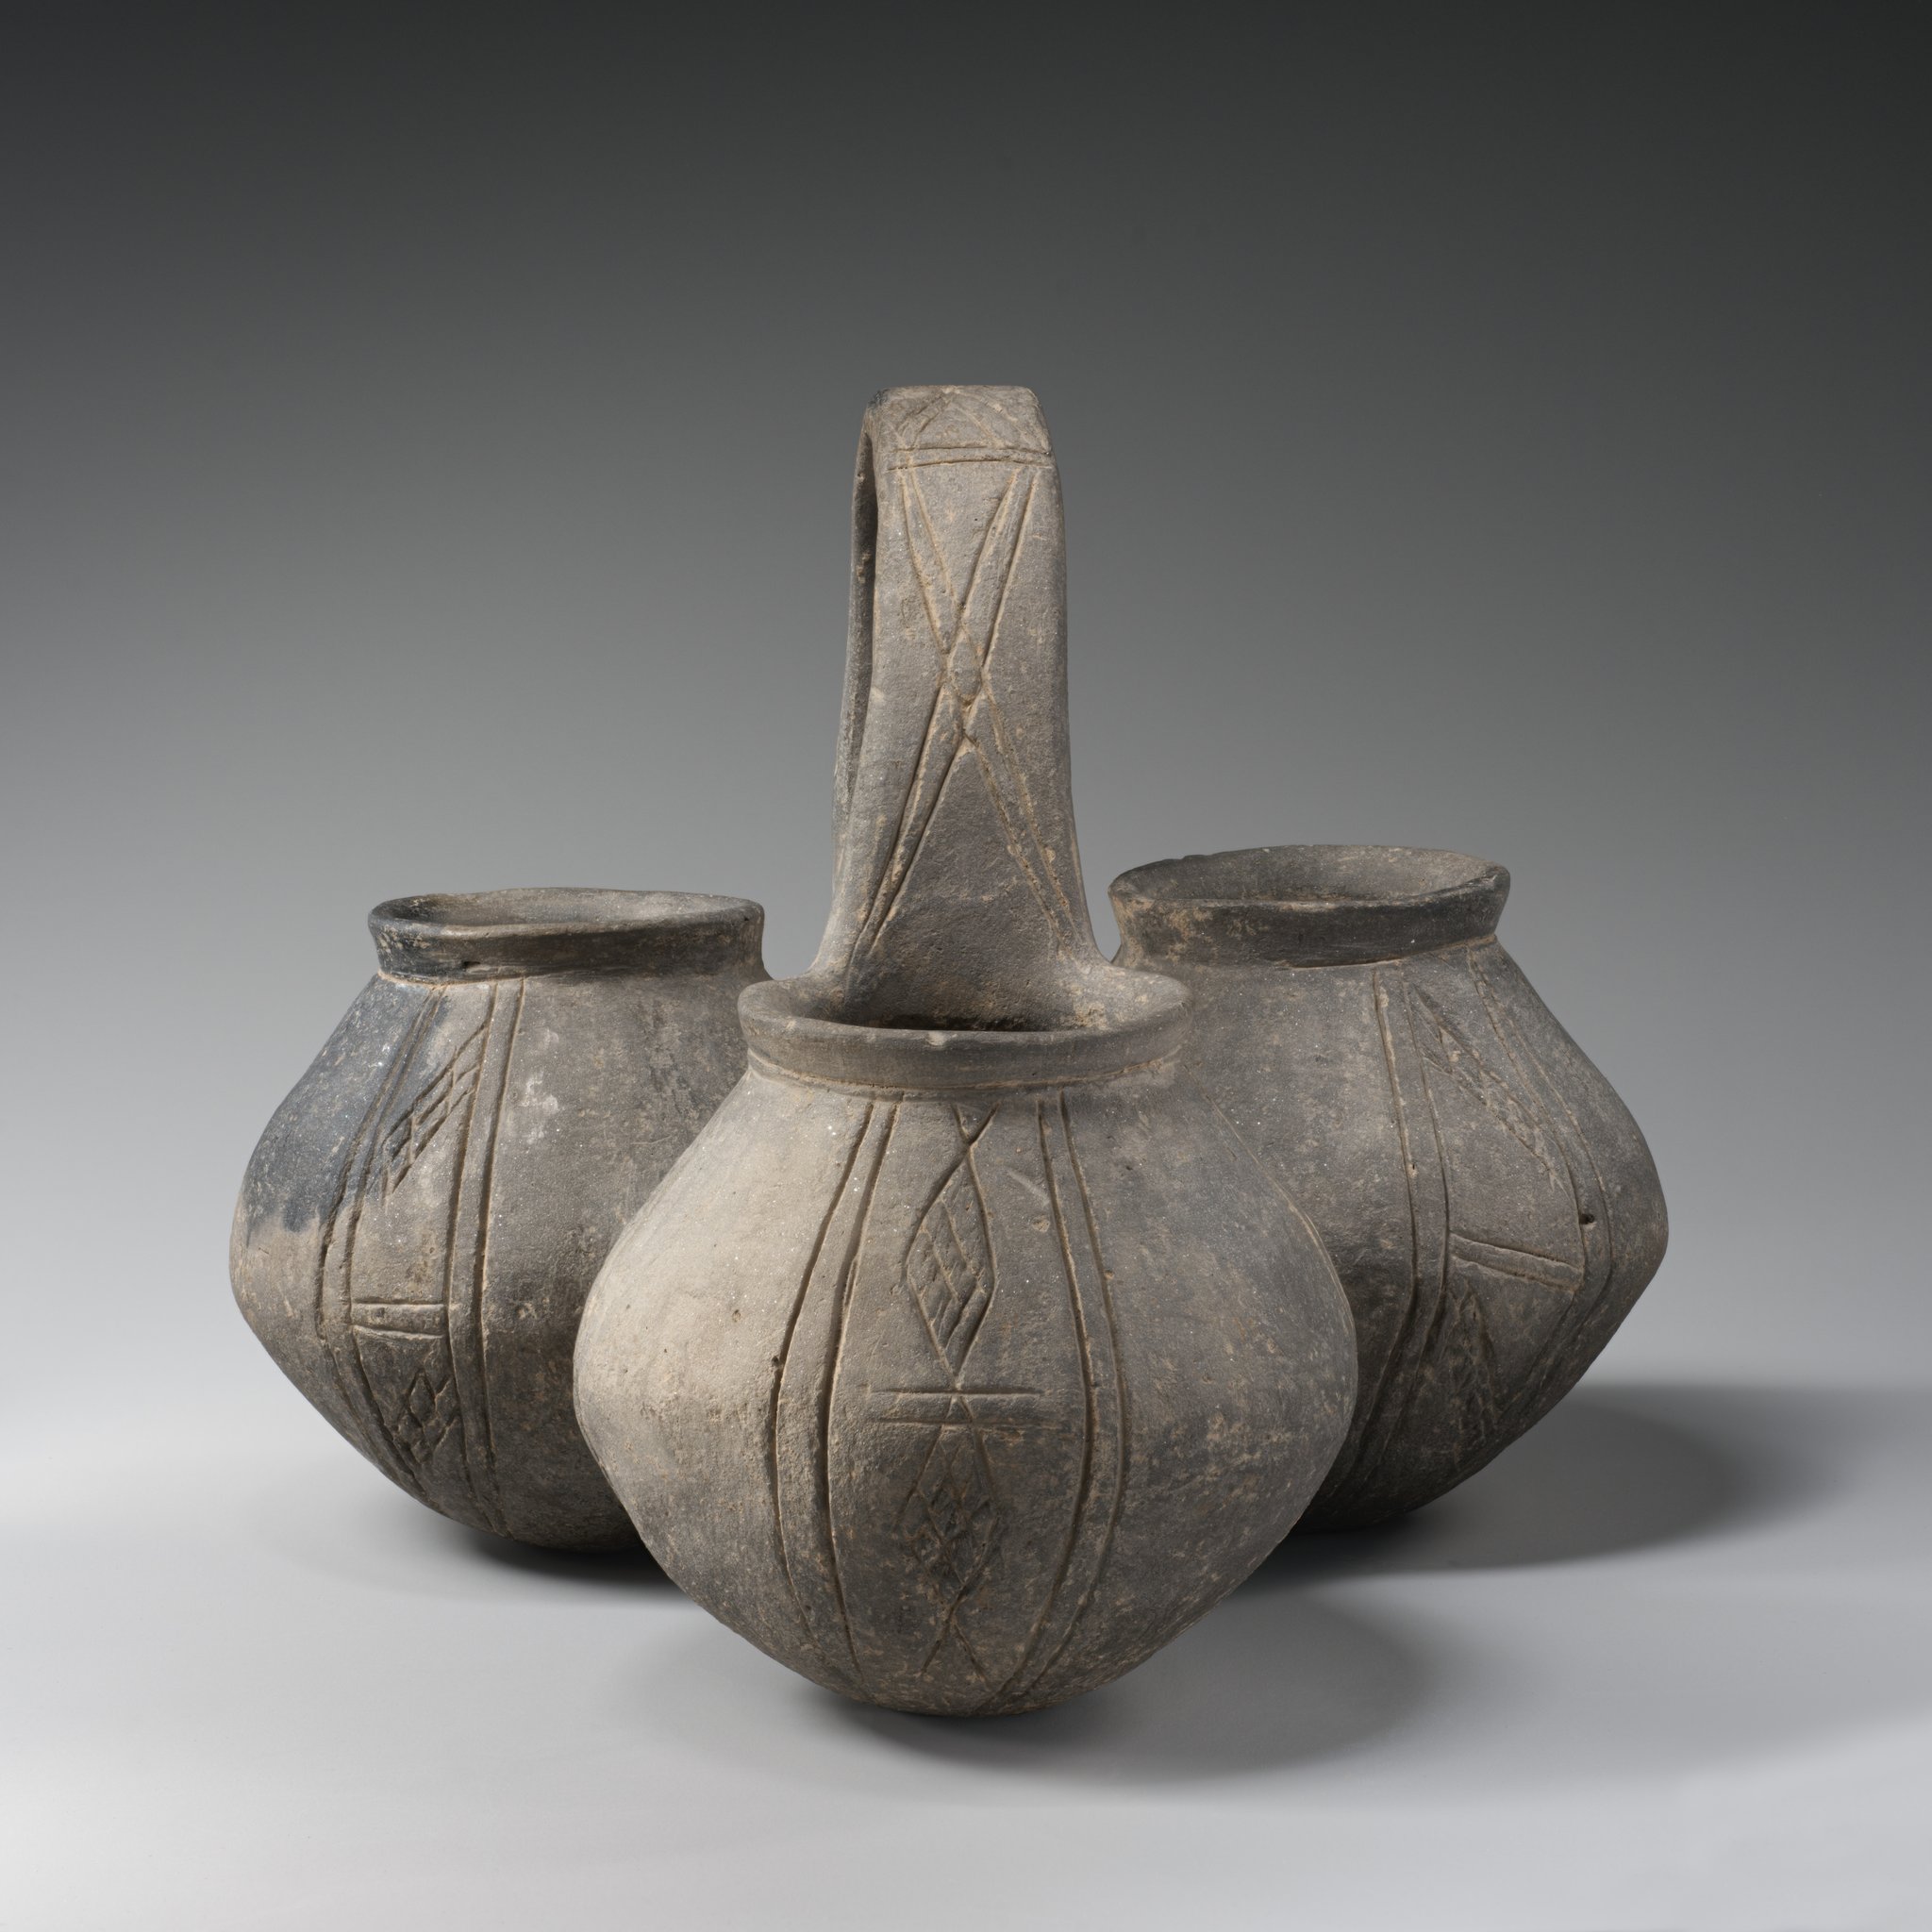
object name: vessel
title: Tripartite vessel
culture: yortan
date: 2700-2400 BCE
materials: ceramic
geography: northwestern anatolia